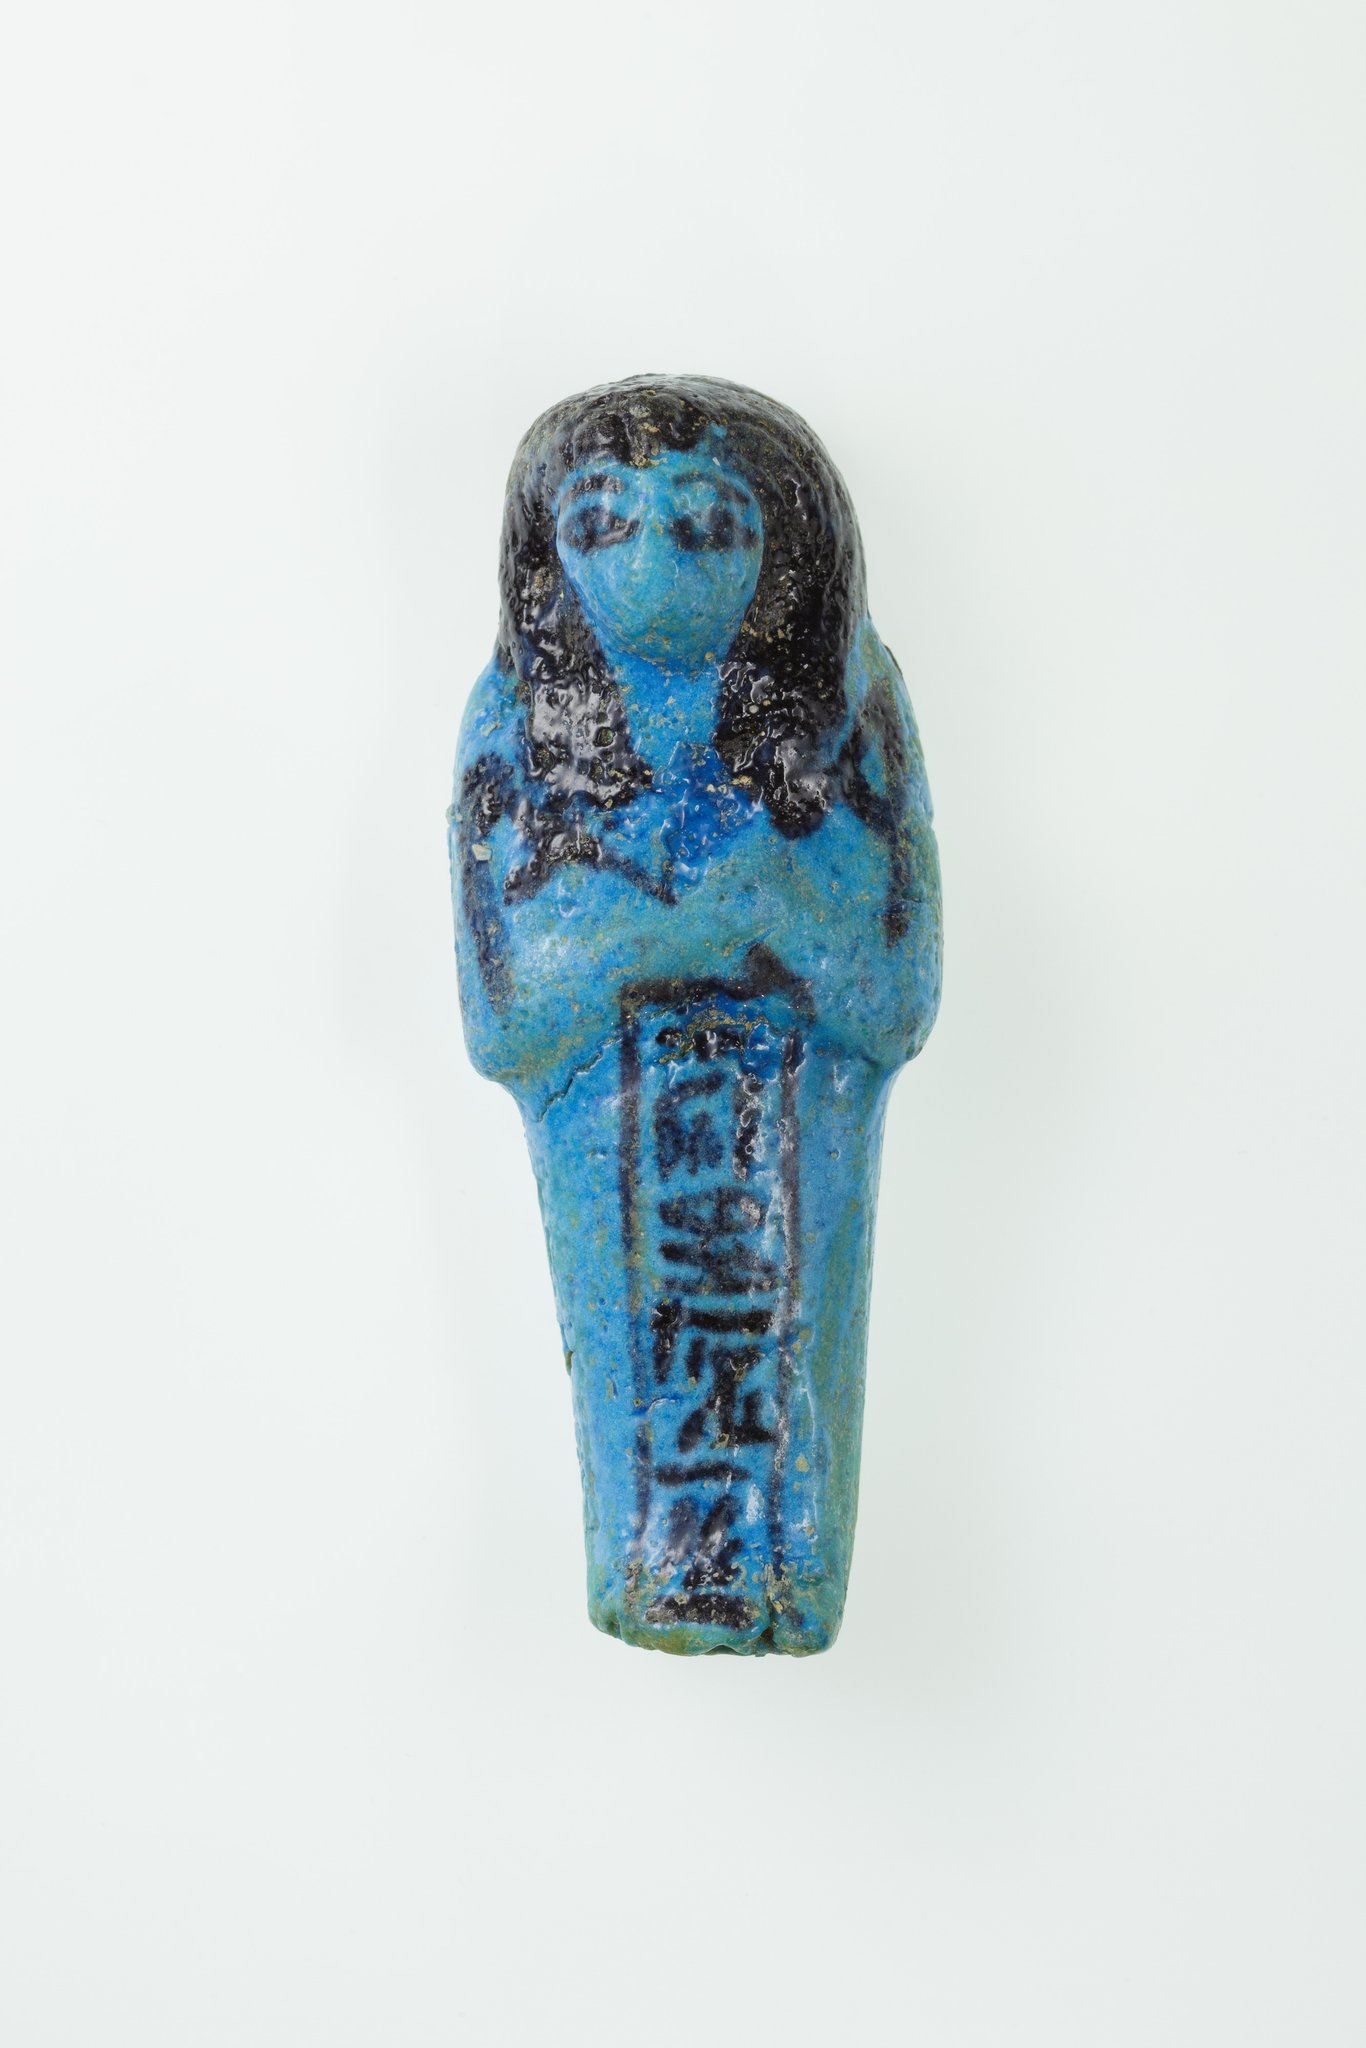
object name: shabti, worker, nauny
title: Worker Shabti of Nauny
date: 1050 BCE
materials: faience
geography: egypt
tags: hieroglyphs